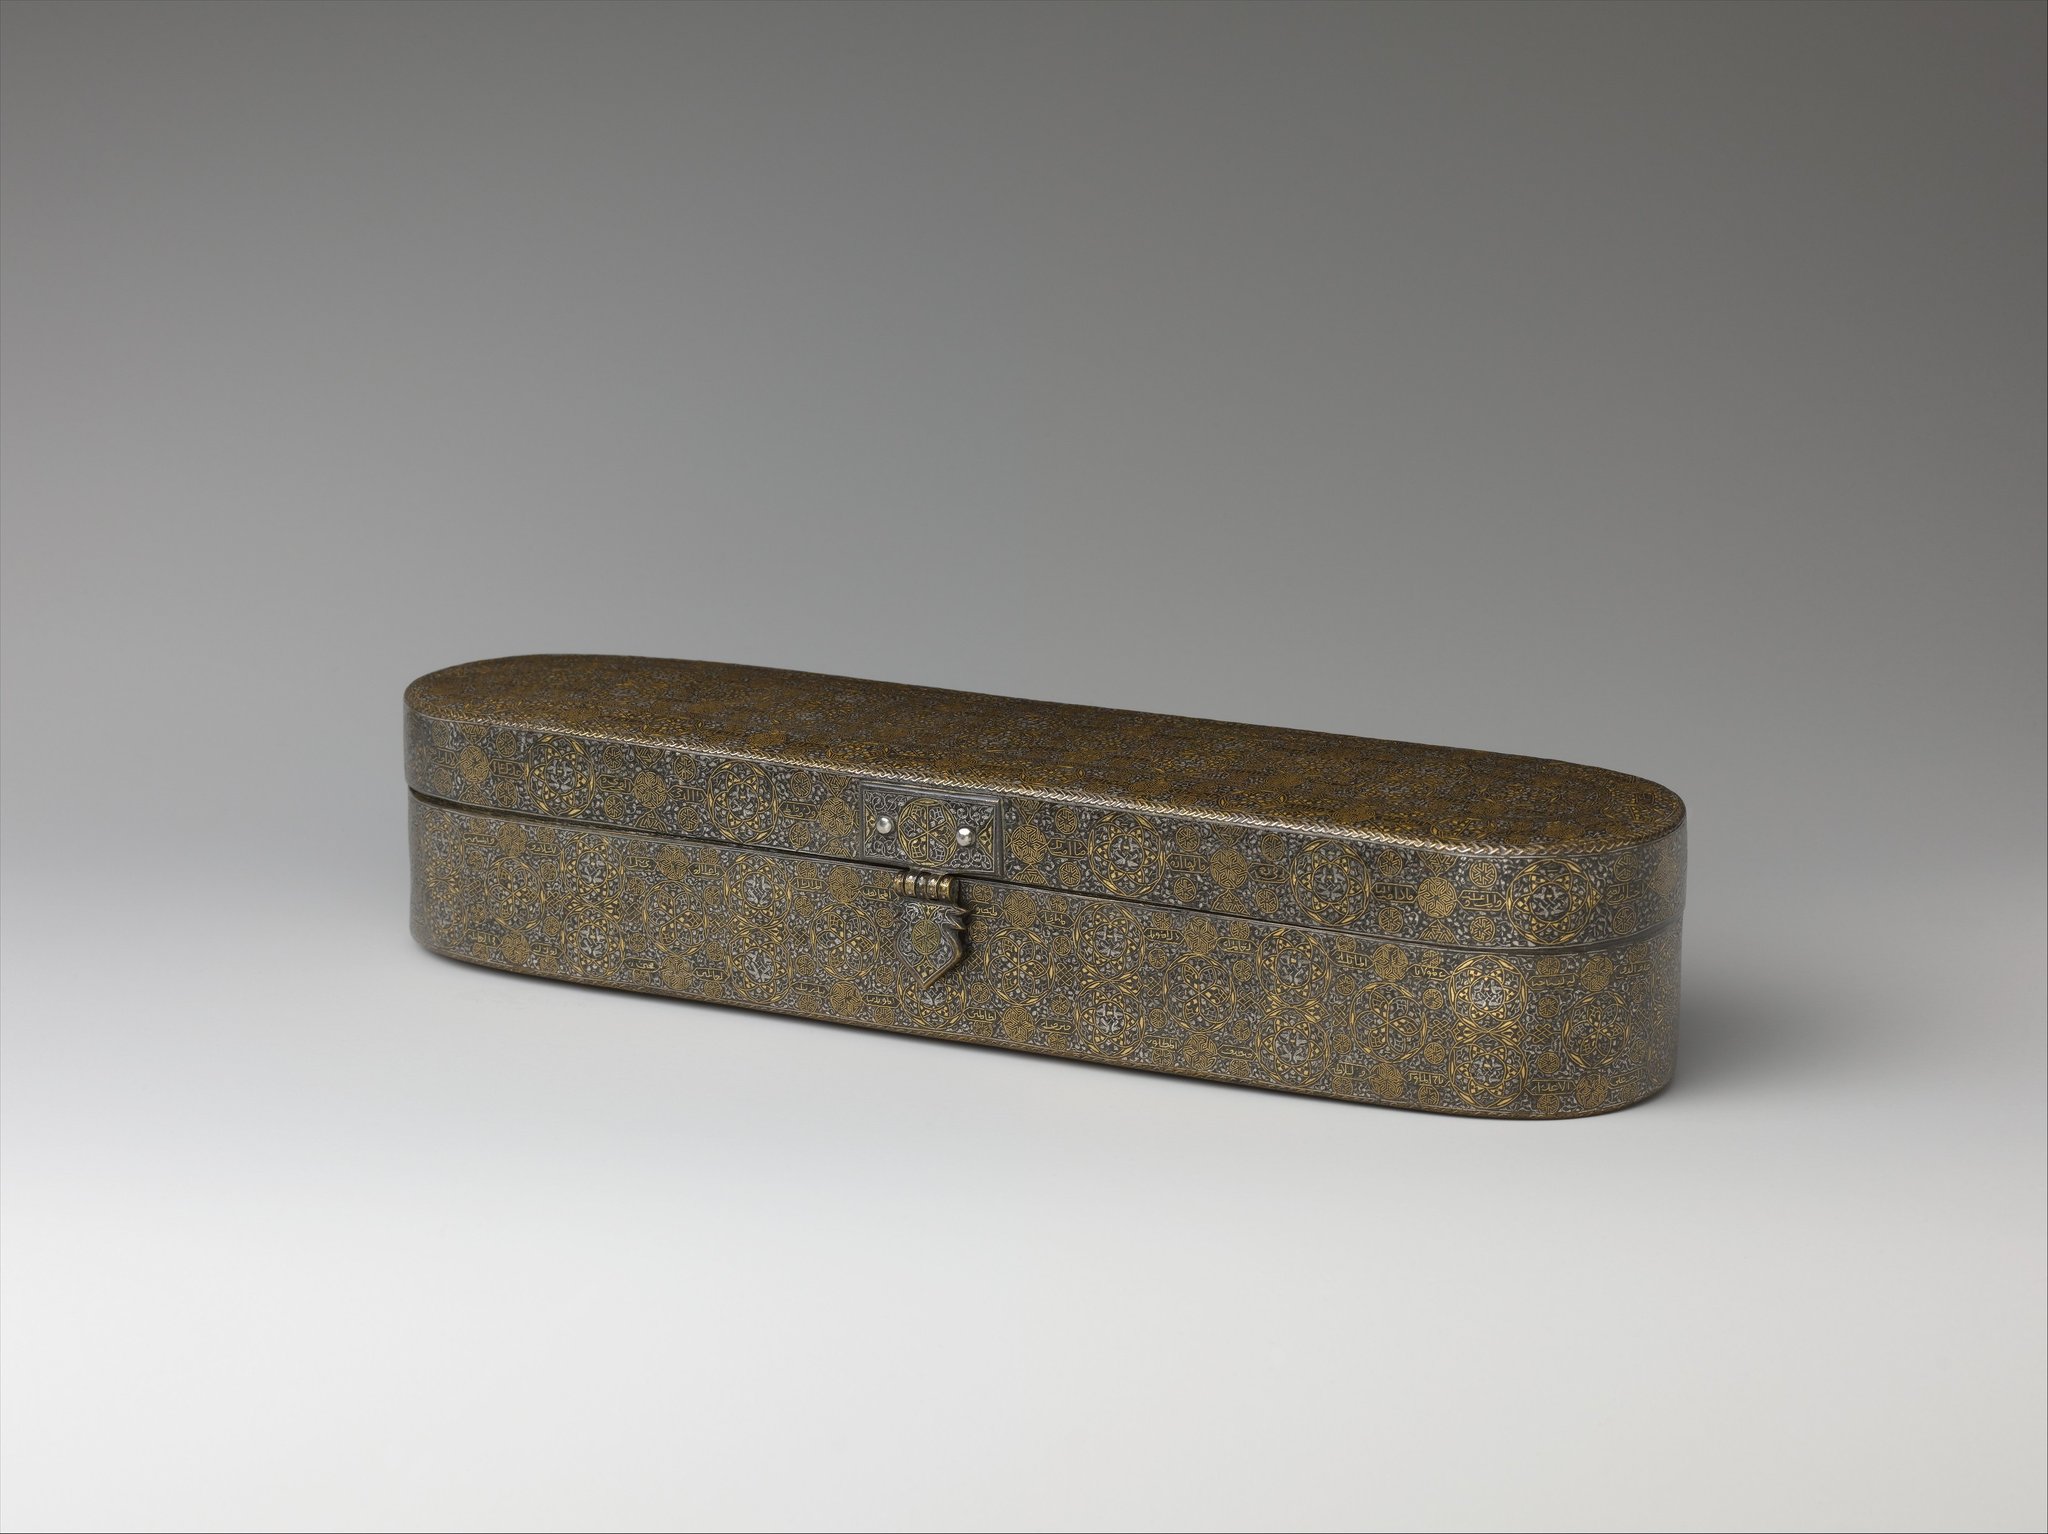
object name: pen box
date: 1267-1333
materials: brass, gold, silver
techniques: inlay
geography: iran